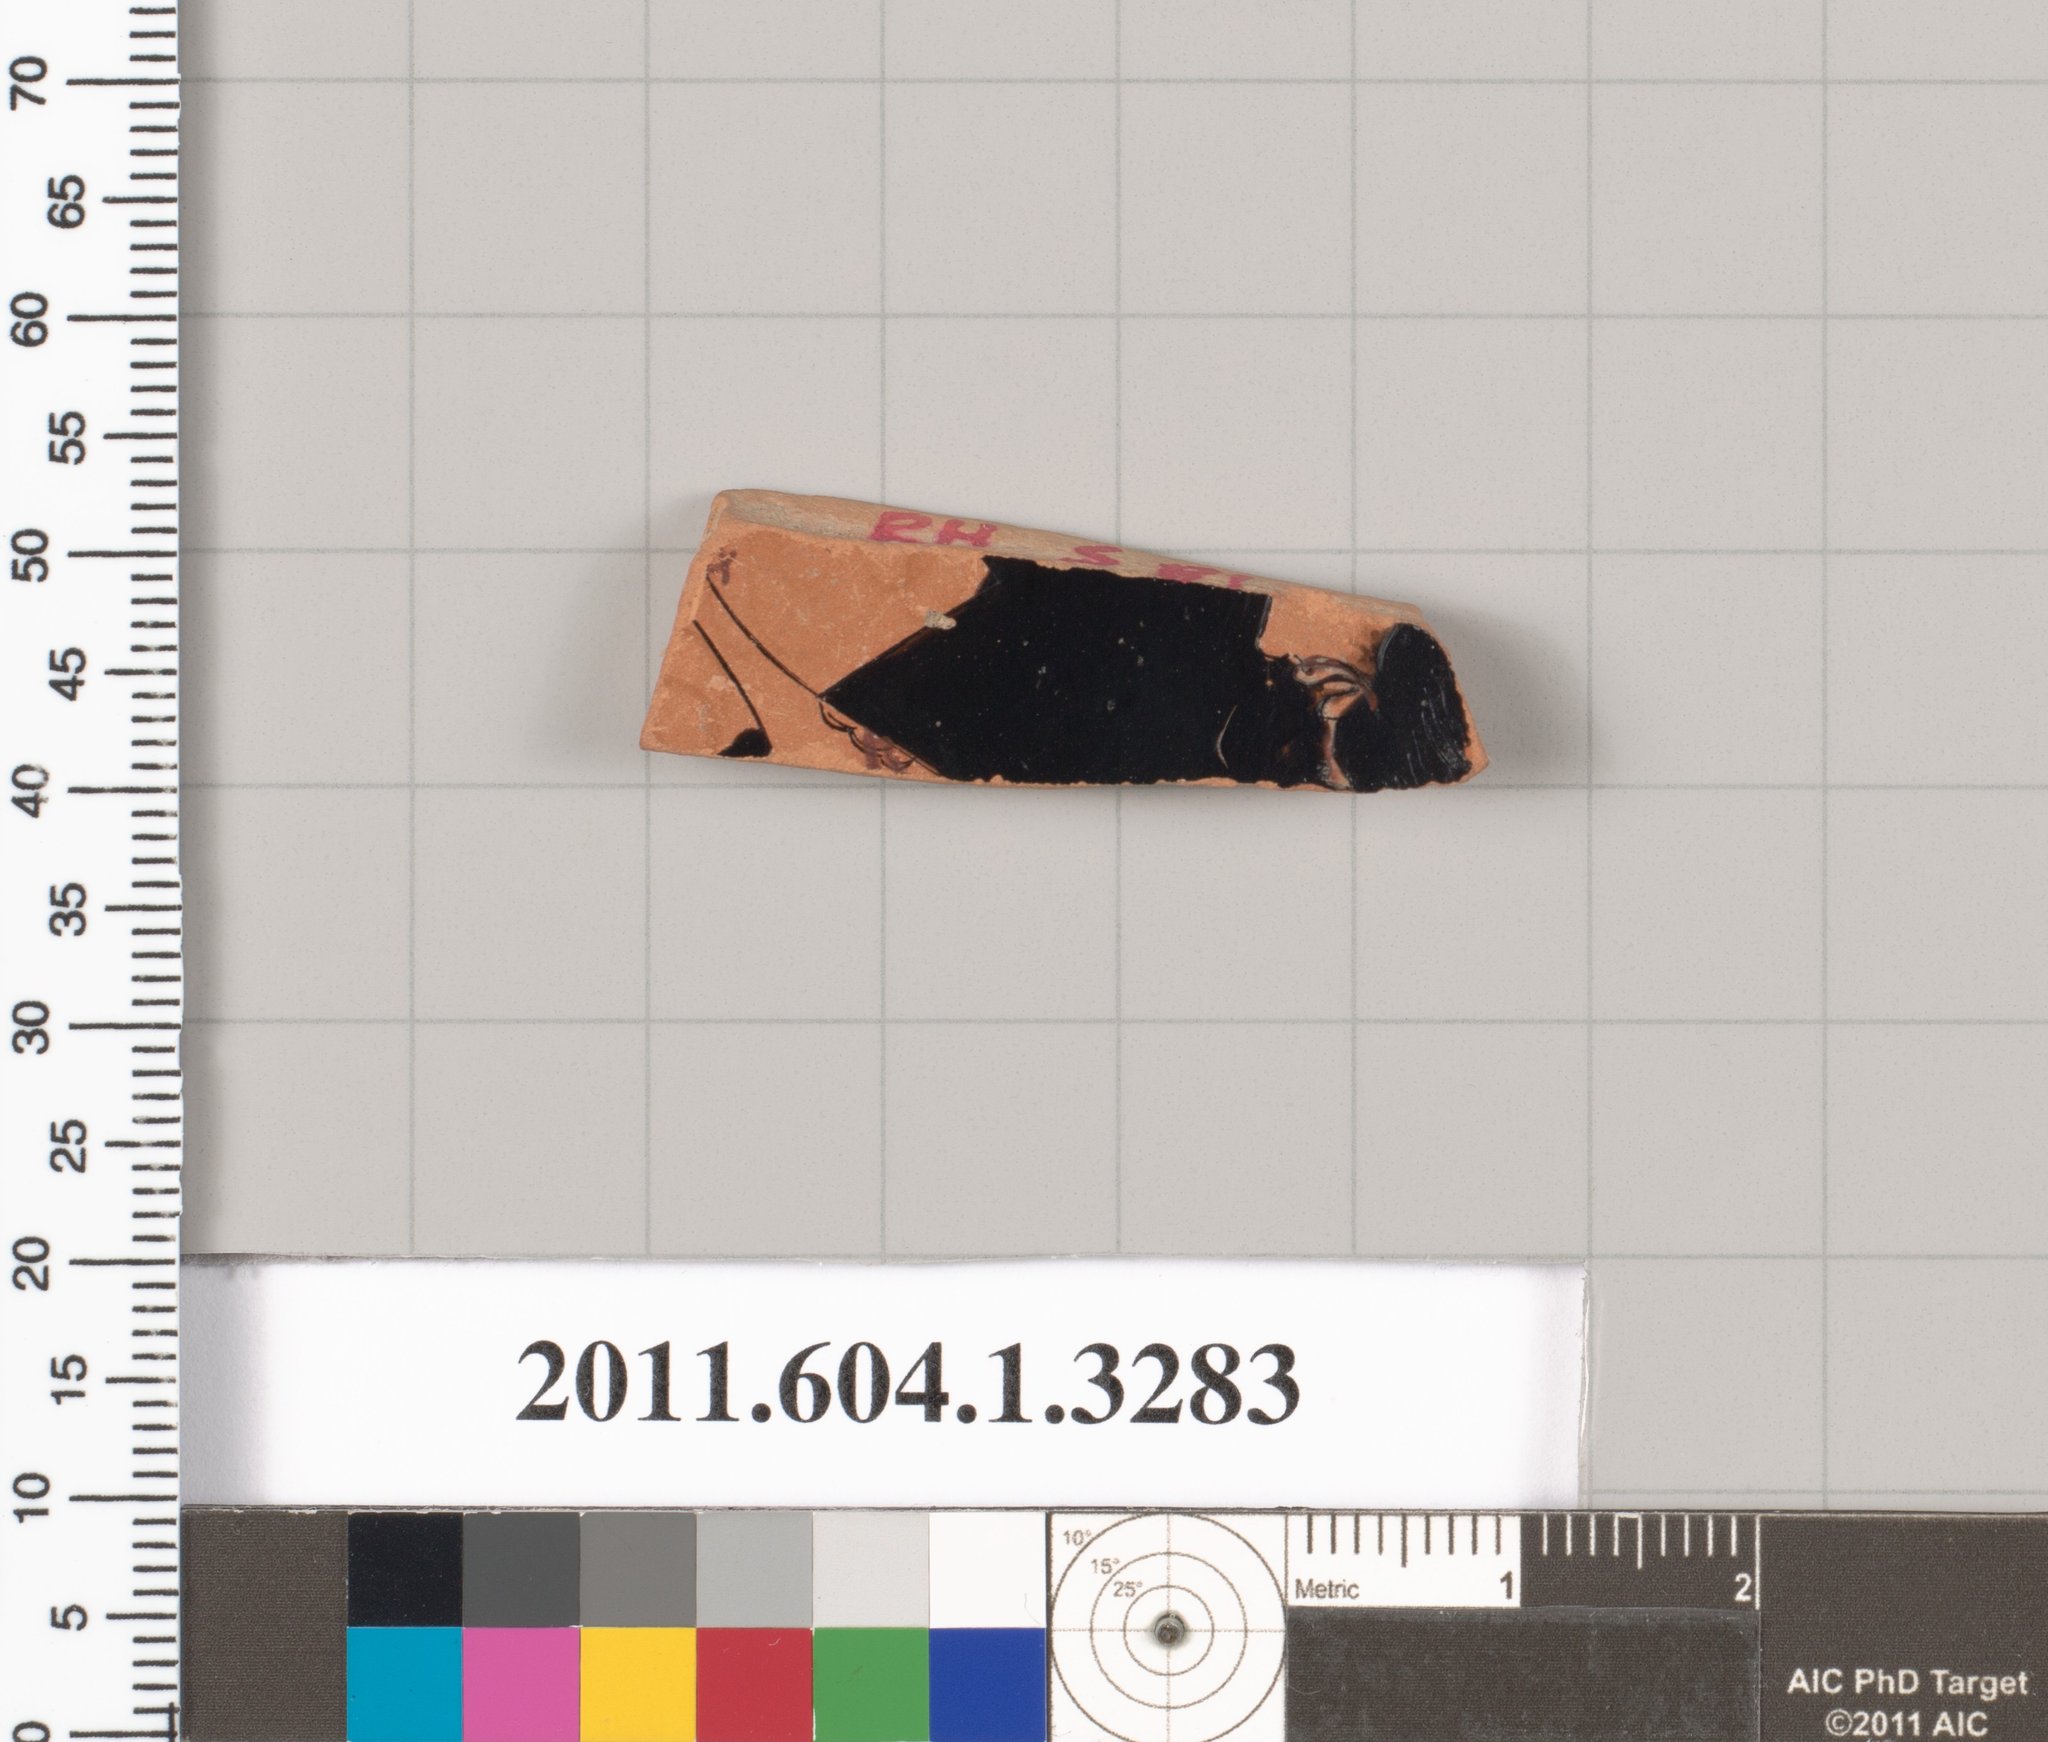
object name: kylix fragment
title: Terracotta fragment of a kylix (drinking cup)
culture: greek, attic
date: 500-476 BCE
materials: terracotta